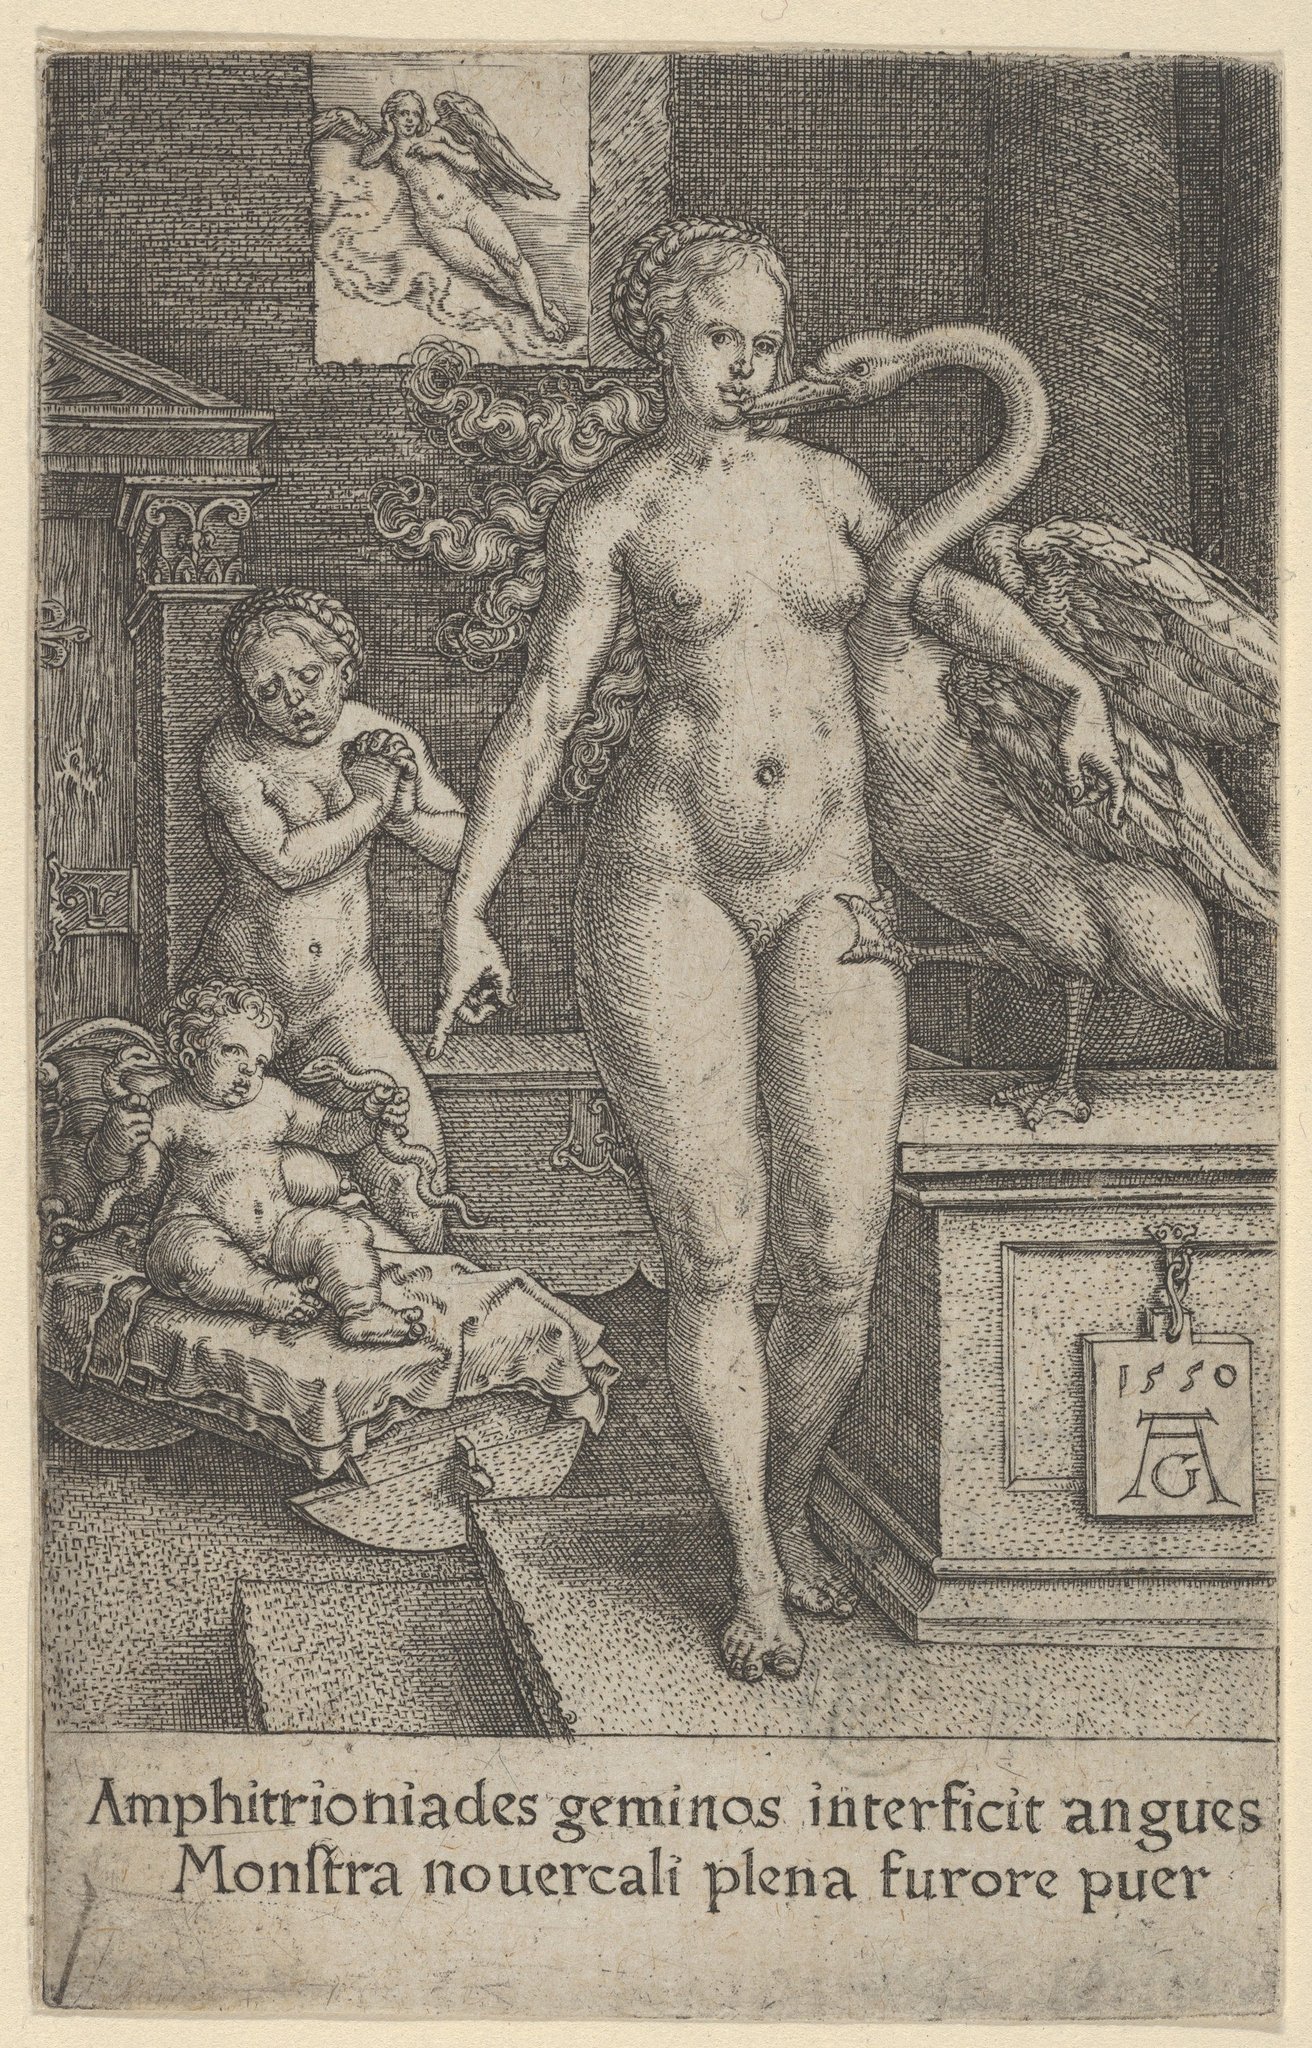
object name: print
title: Leda with the Swan and Hercules as a Child, from The Labors of Hercules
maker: heinrich aldegrever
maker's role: artist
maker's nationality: german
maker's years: 1502-1561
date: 1550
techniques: engraving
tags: hercules,leda,swans